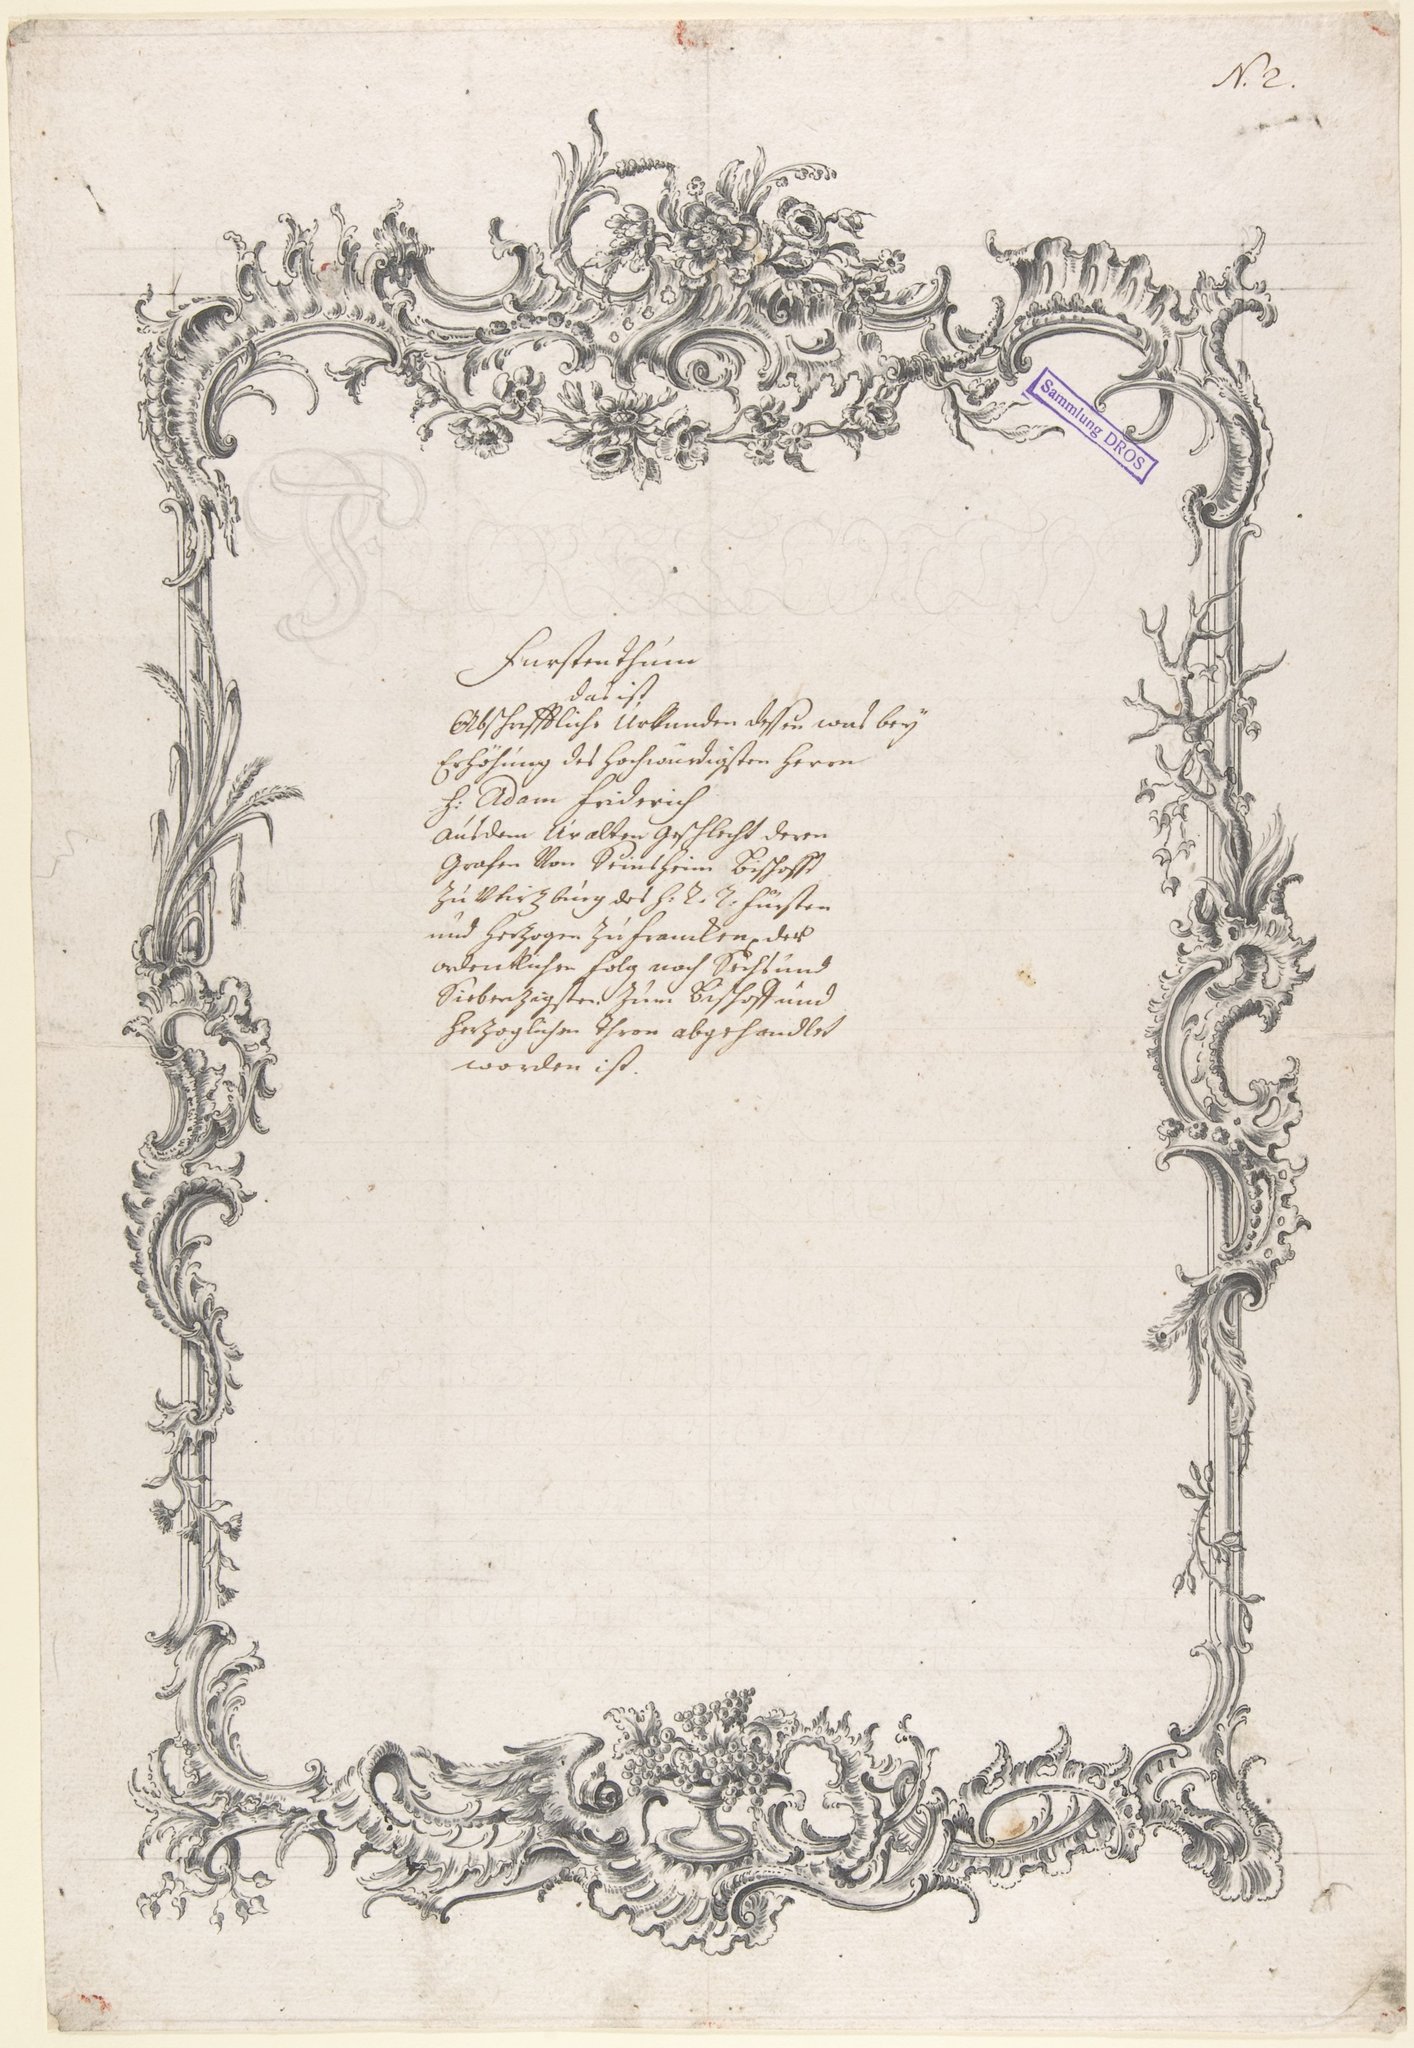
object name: drawing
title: Design for a Frame with Flowers, Feathers, Leaves, and Grapes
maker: johann oktavian salver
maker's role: artist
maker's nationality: german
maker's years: 1732-1788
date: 1750-1788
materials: chalk, ink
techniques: brush, incising, transfer, wash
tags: grapes,feathers,flowers,leaves